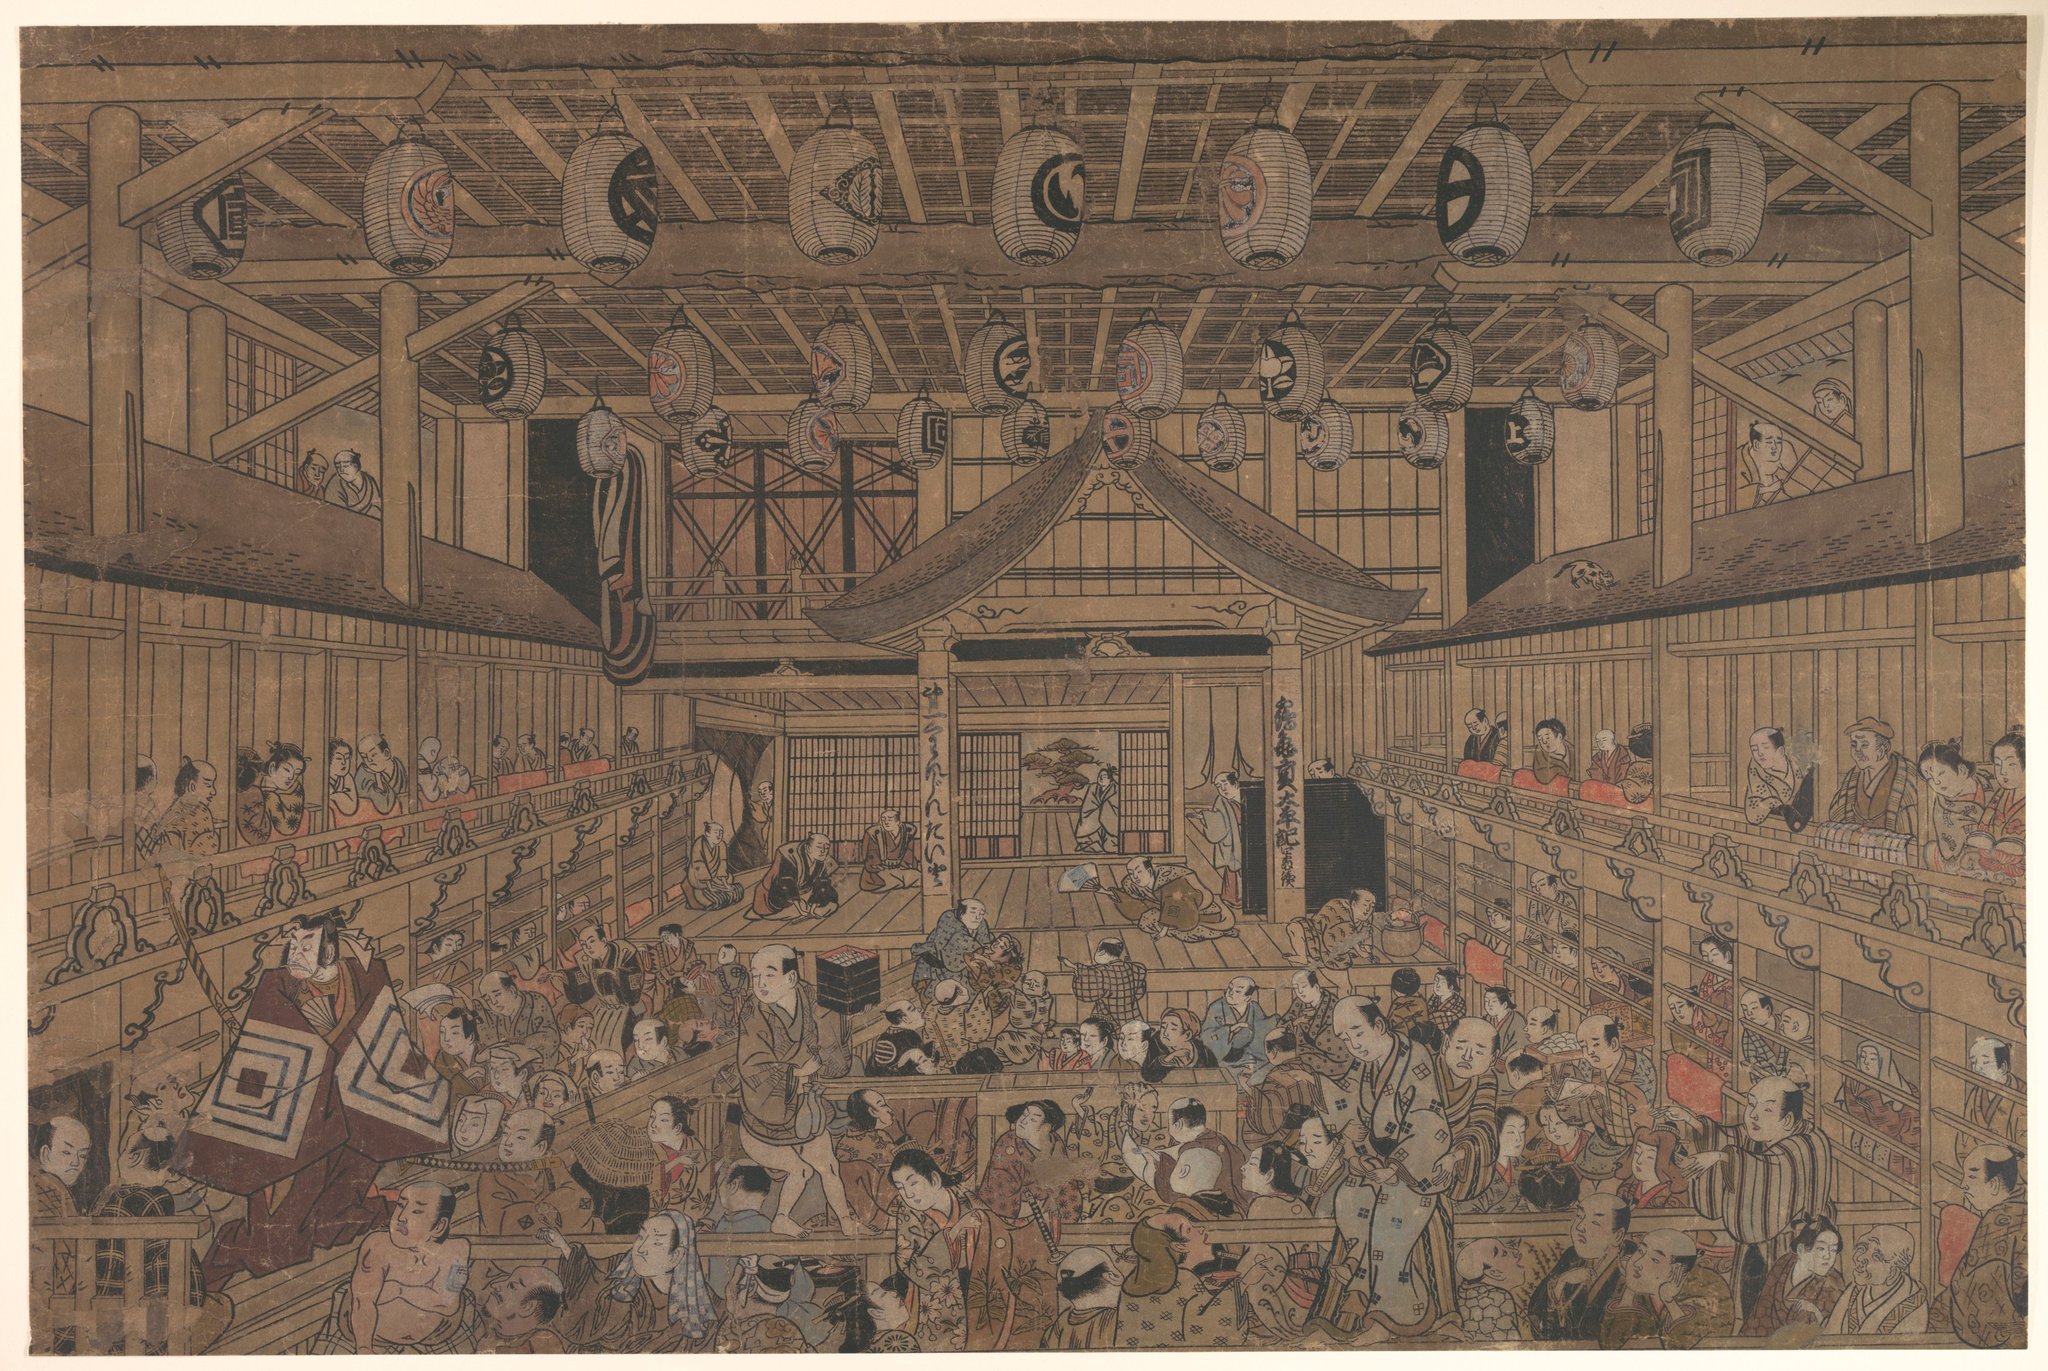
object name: woodblock print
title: Ichikawa Danjūrō II (?) Performing Shibaraku in the Ichimura Theater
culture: japanese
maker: torii kiyotada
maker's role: artist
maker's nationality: japanese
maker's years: 1720-1750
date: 1738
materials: ink, paper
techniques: woodblock print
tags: performance,theatre,interiors,spectators